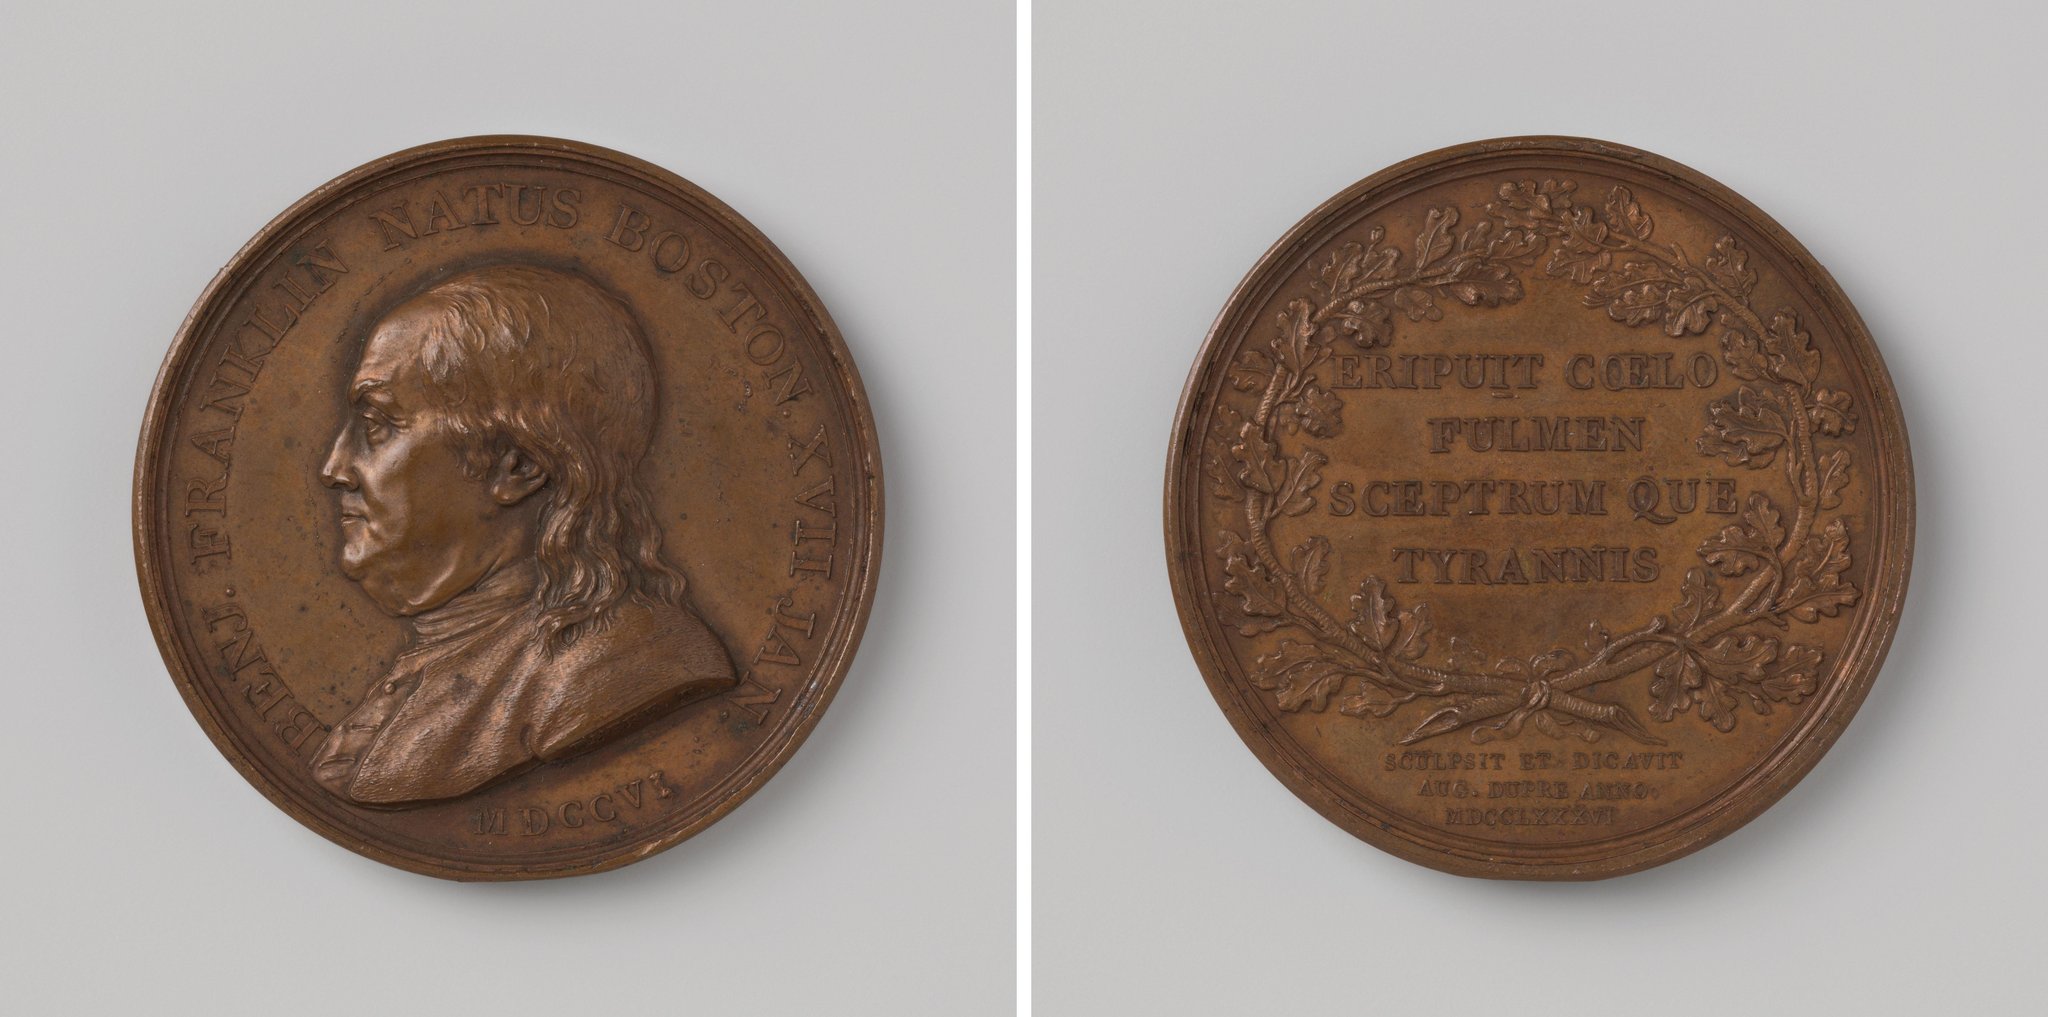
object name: history medal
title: Benjamin Franklin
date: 1786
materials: bronze, silver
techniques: striking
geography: amsterdam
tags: physicist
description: Zilveren of bronzen penning. Voorzijde: borststuk man binnen omschrift. Keerzijde: opschrift binnen eikenkrans boven opschrift.